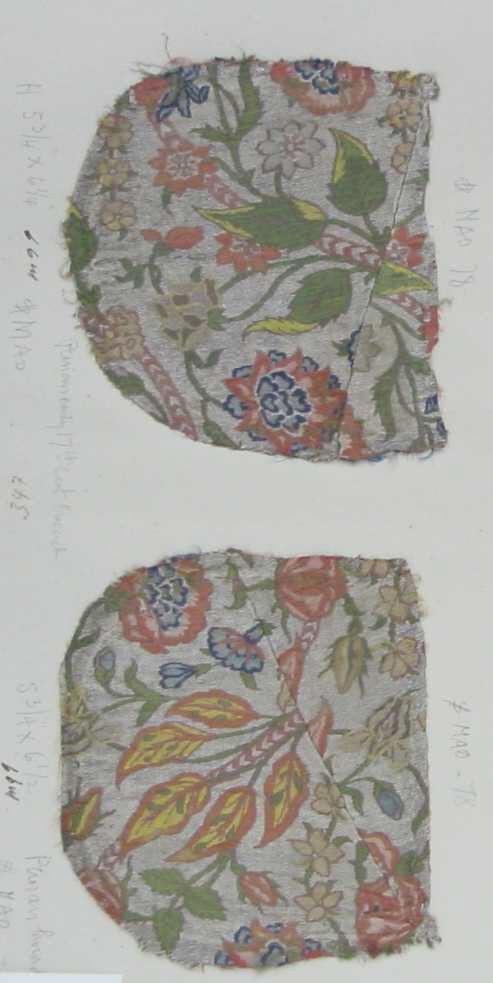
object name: textile fragment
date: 1601-1700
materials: metal thread, silk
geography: iran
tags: flowers,leaves